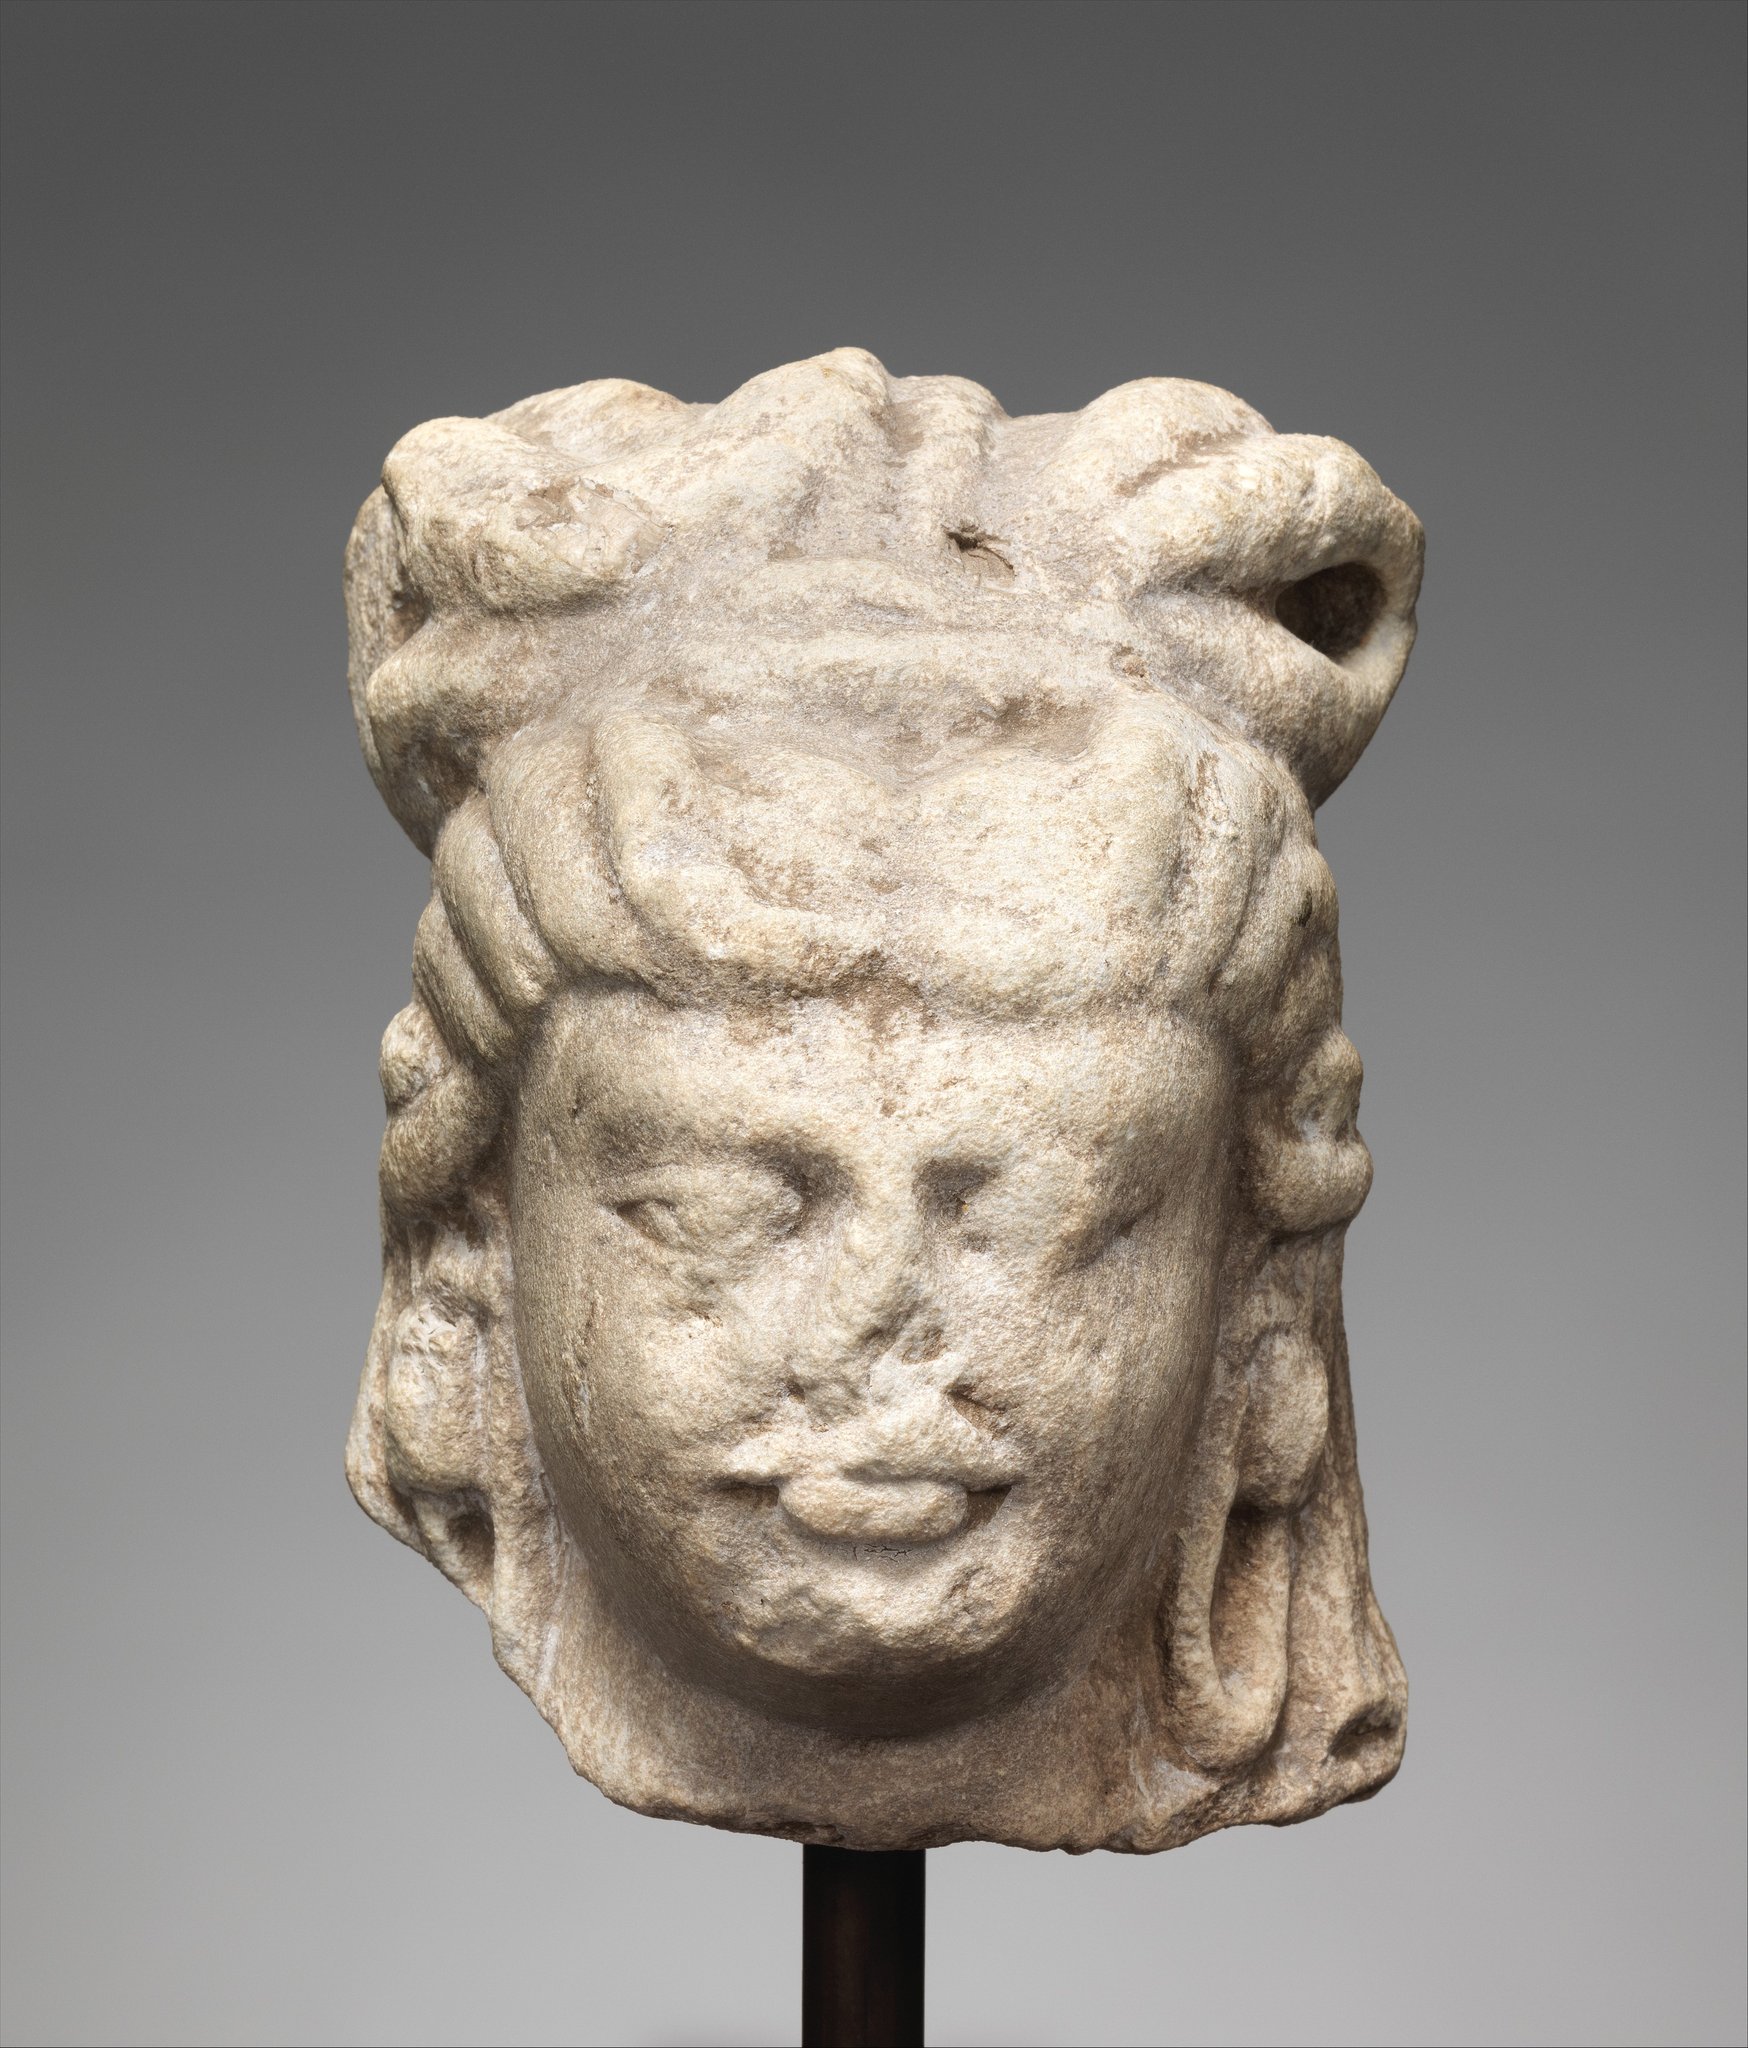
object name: figure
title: Head of Shiva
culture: pakistani, brahmanical post-gupta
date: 501-600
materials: mineral, stone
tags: gandhara,shiva,hinduism